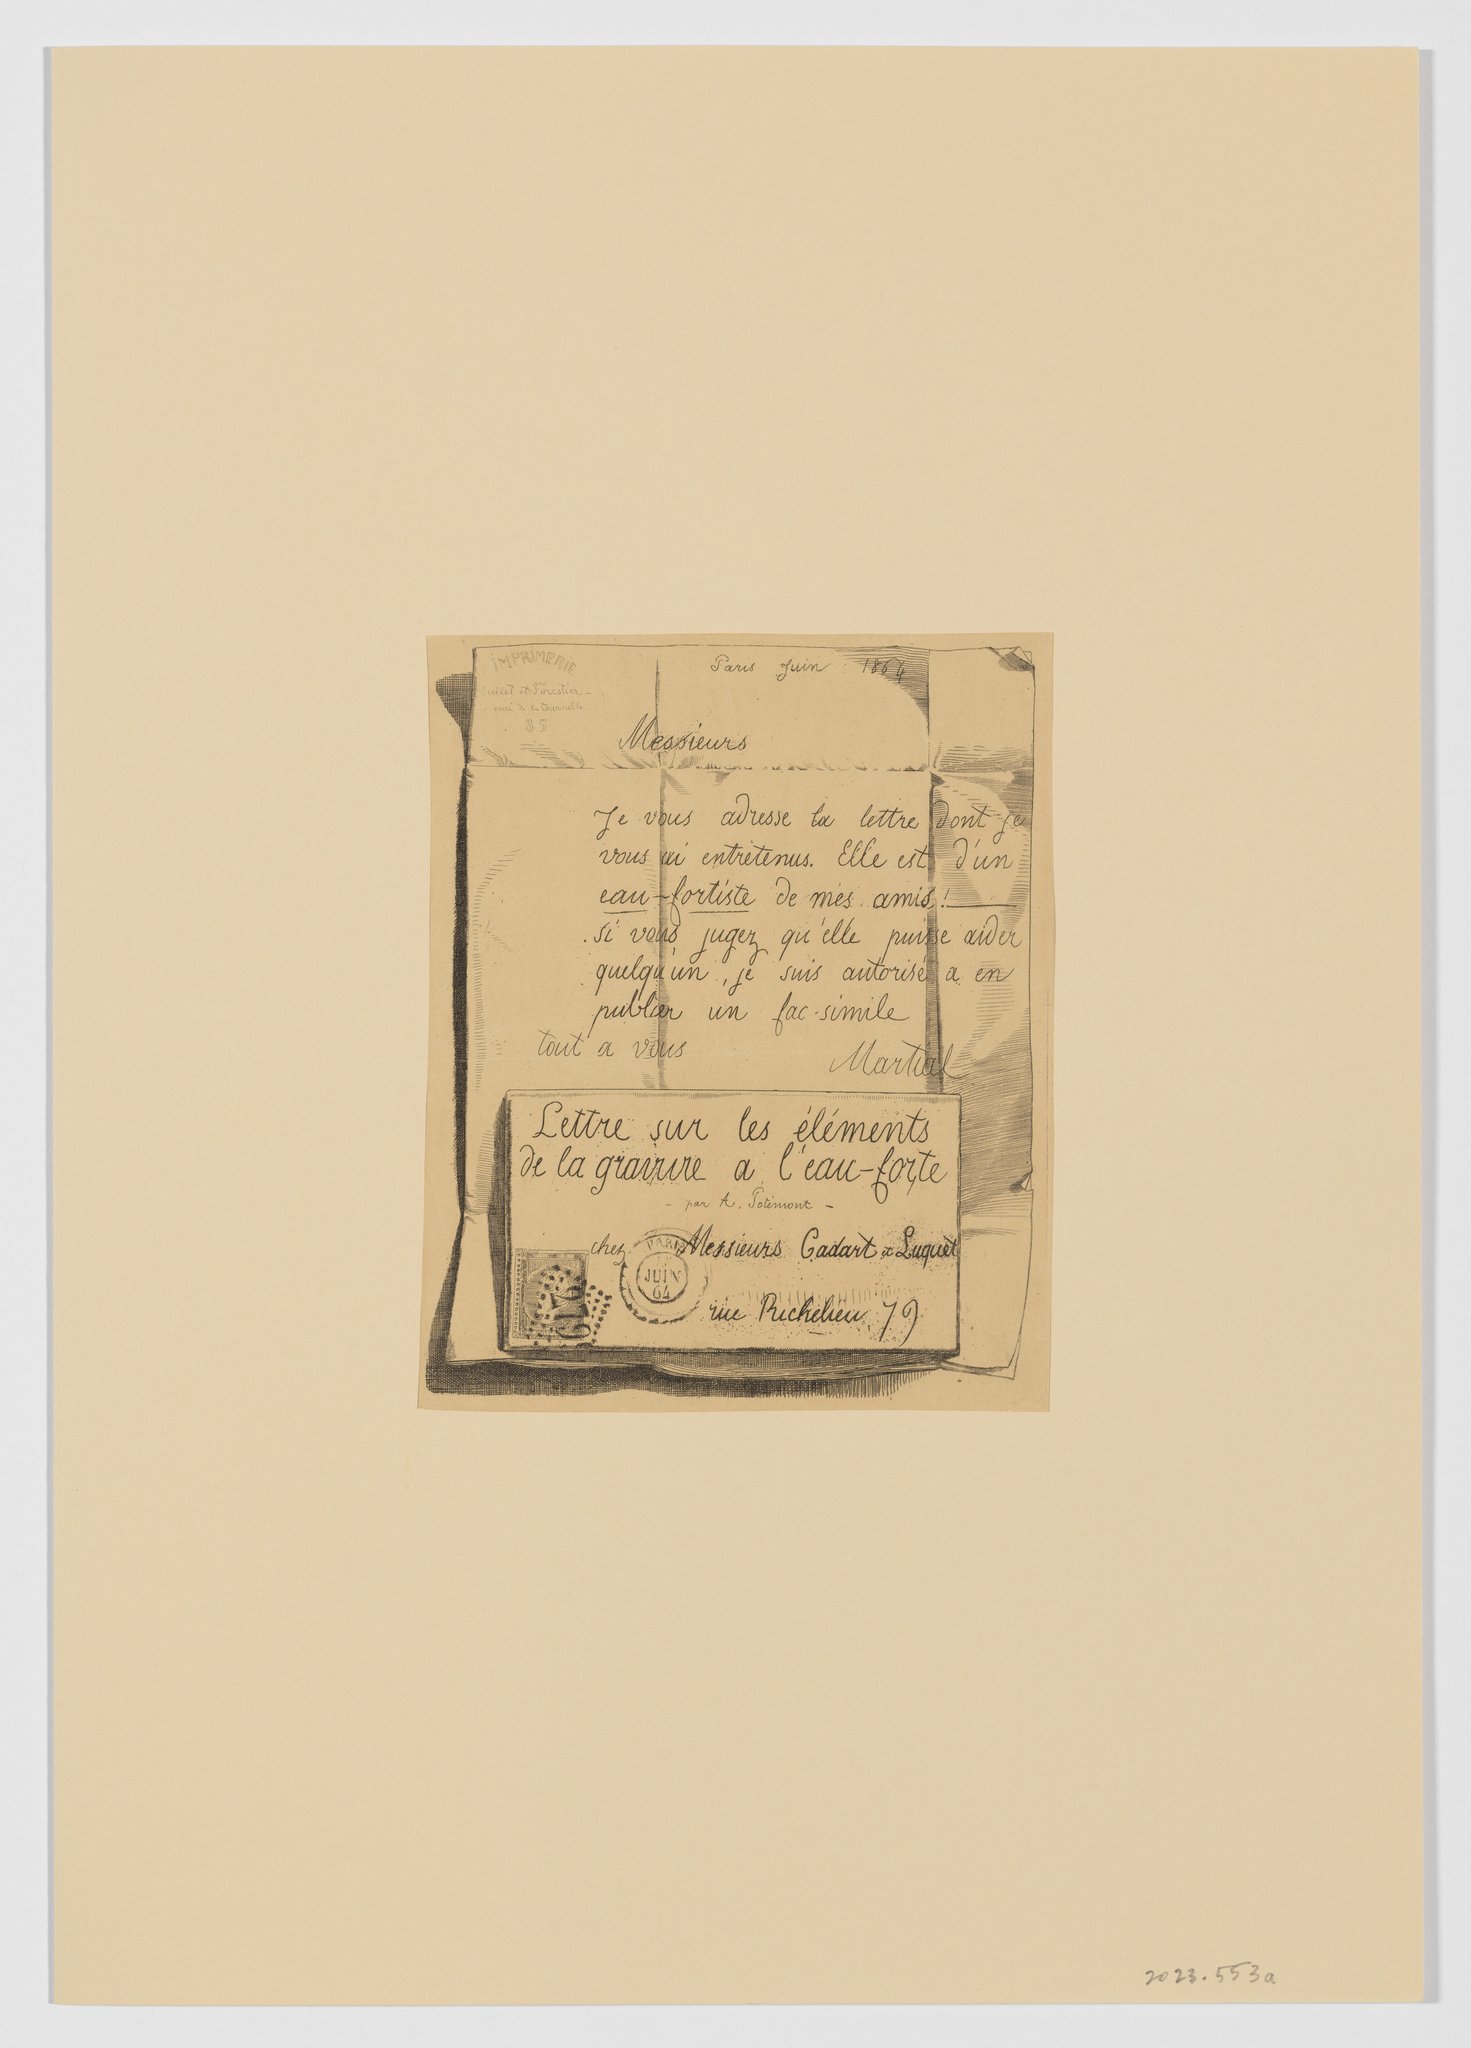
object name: print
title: Lettre sur les éléments de la gravure à l'eau-forte (Letter on the Elements of Etching)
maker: adolphe martial potémont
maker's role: artist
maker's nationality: french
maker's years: 1828-1883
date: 1864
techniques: etching